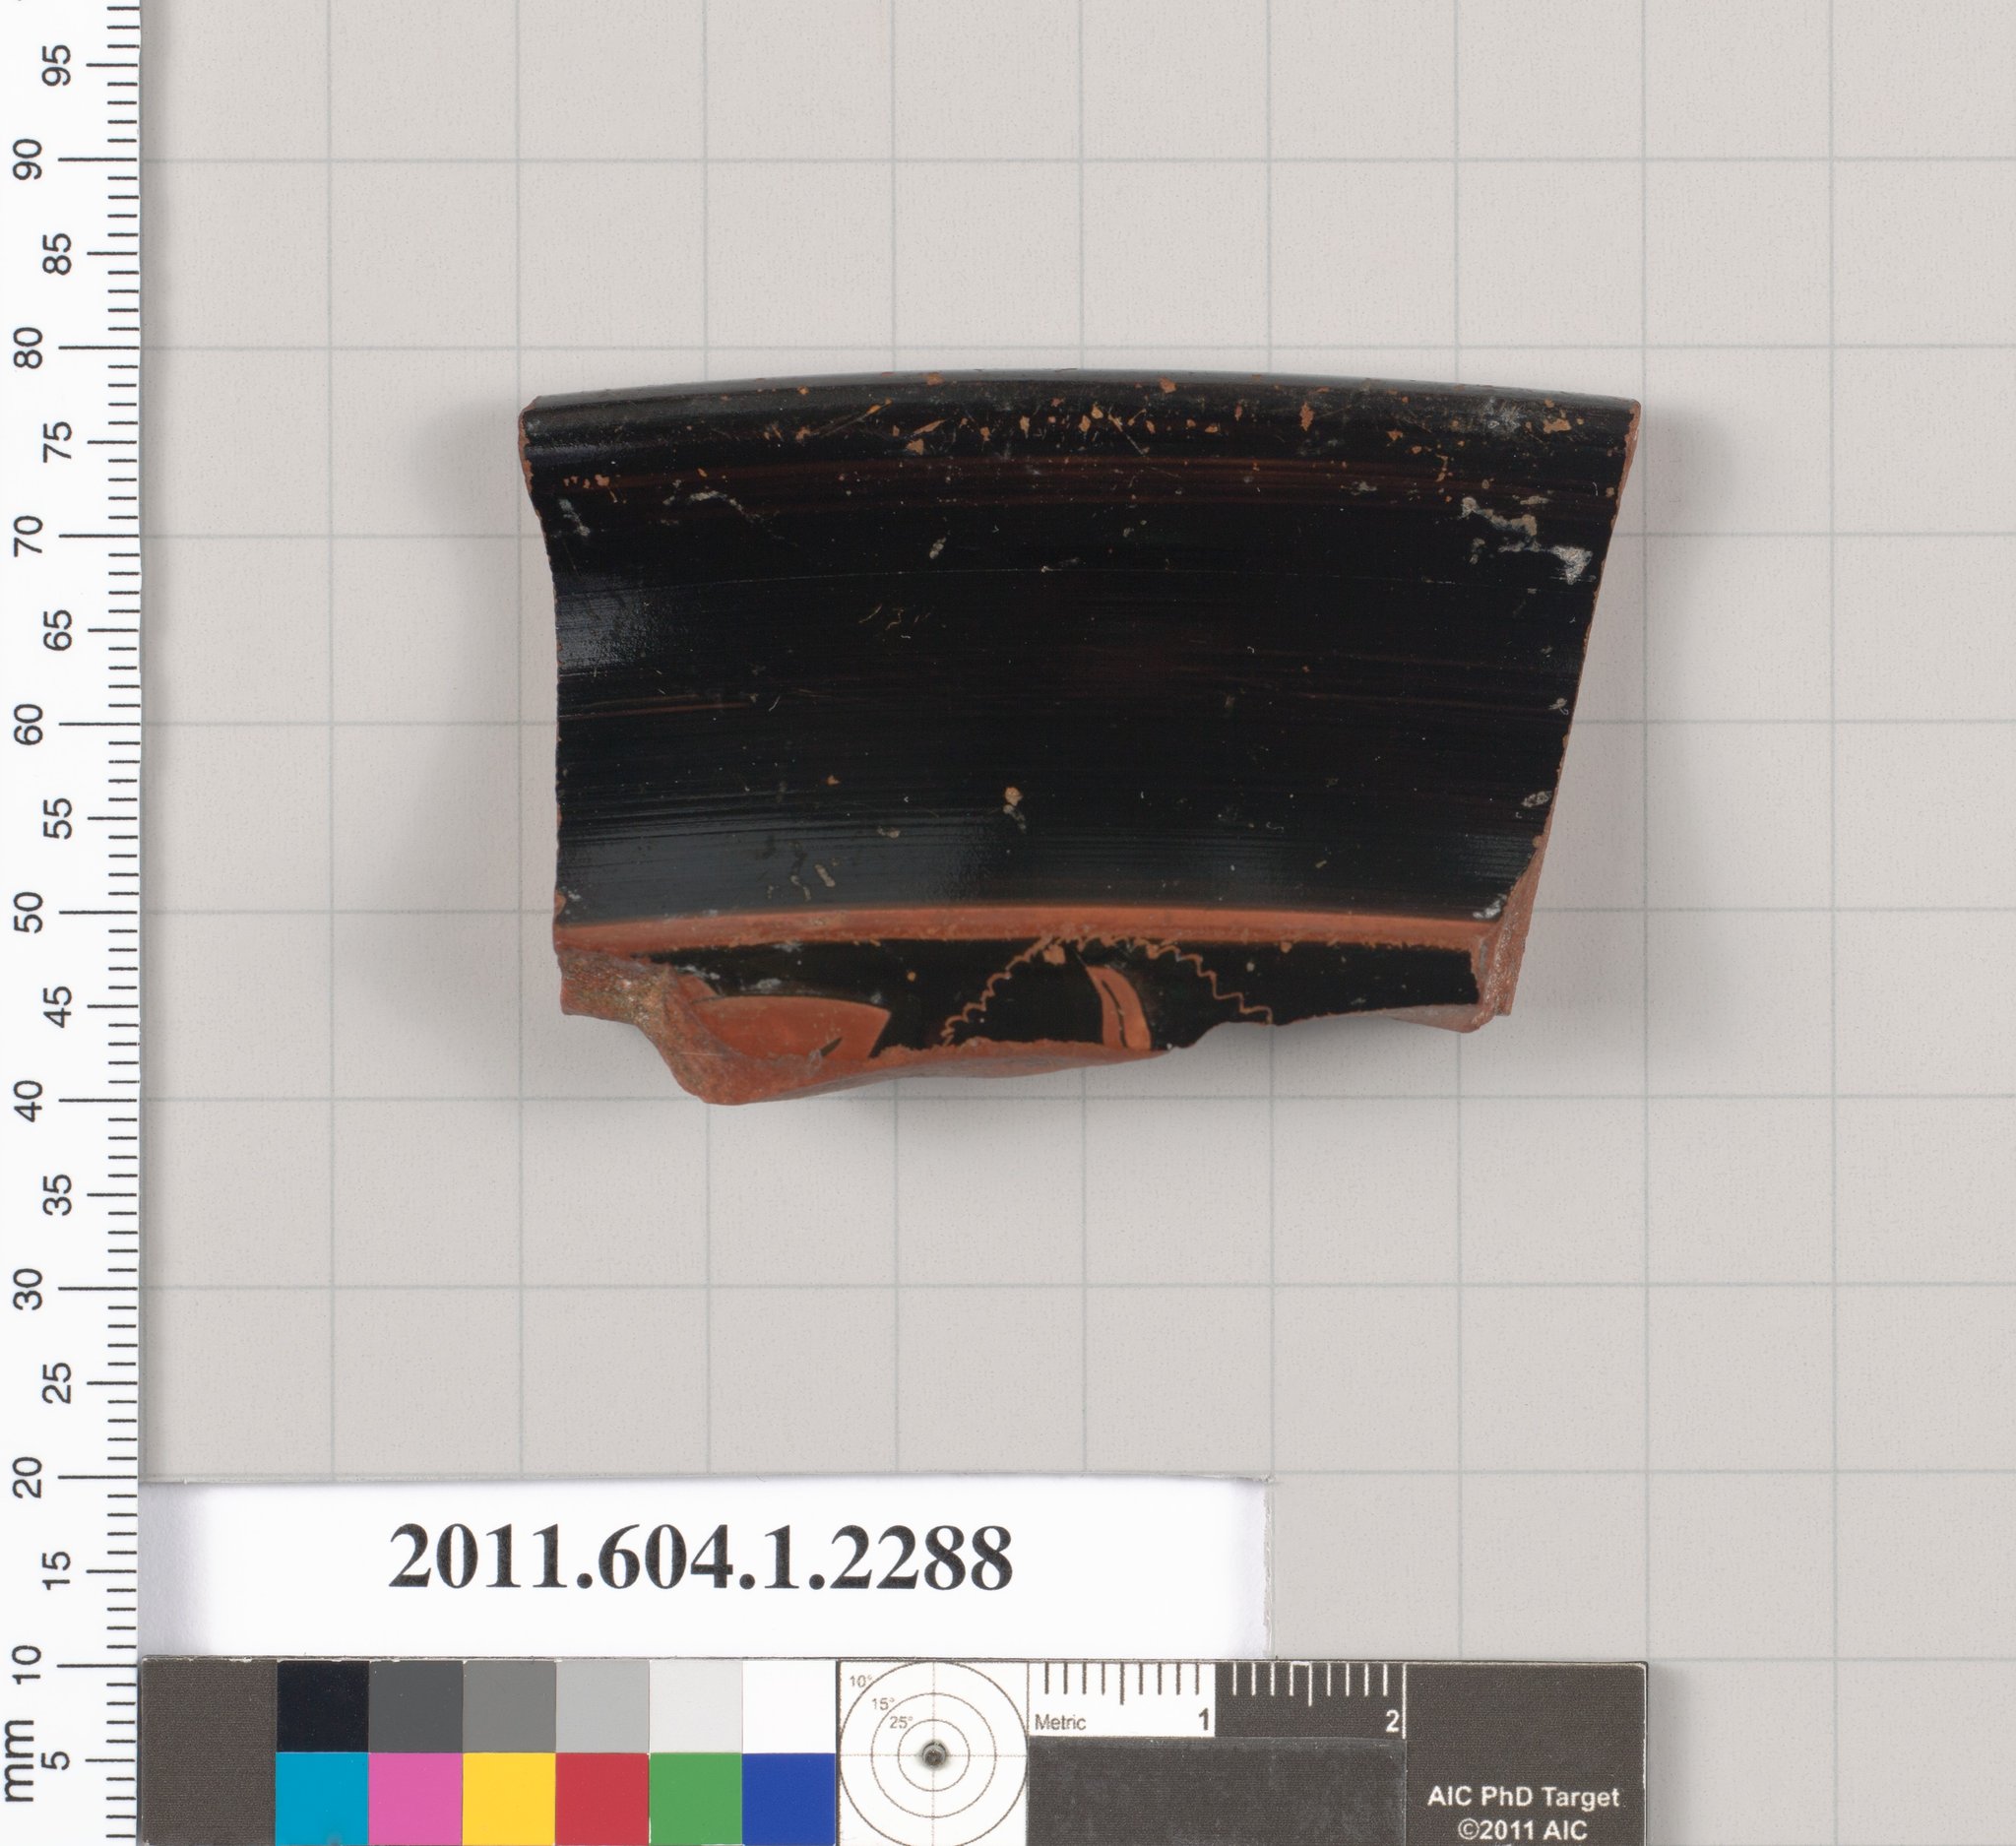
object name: kylix fragment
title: Terracotta rim fragment of a kylix (drinking cup)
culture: greek, attic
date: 500-480 BCE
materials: terracotta